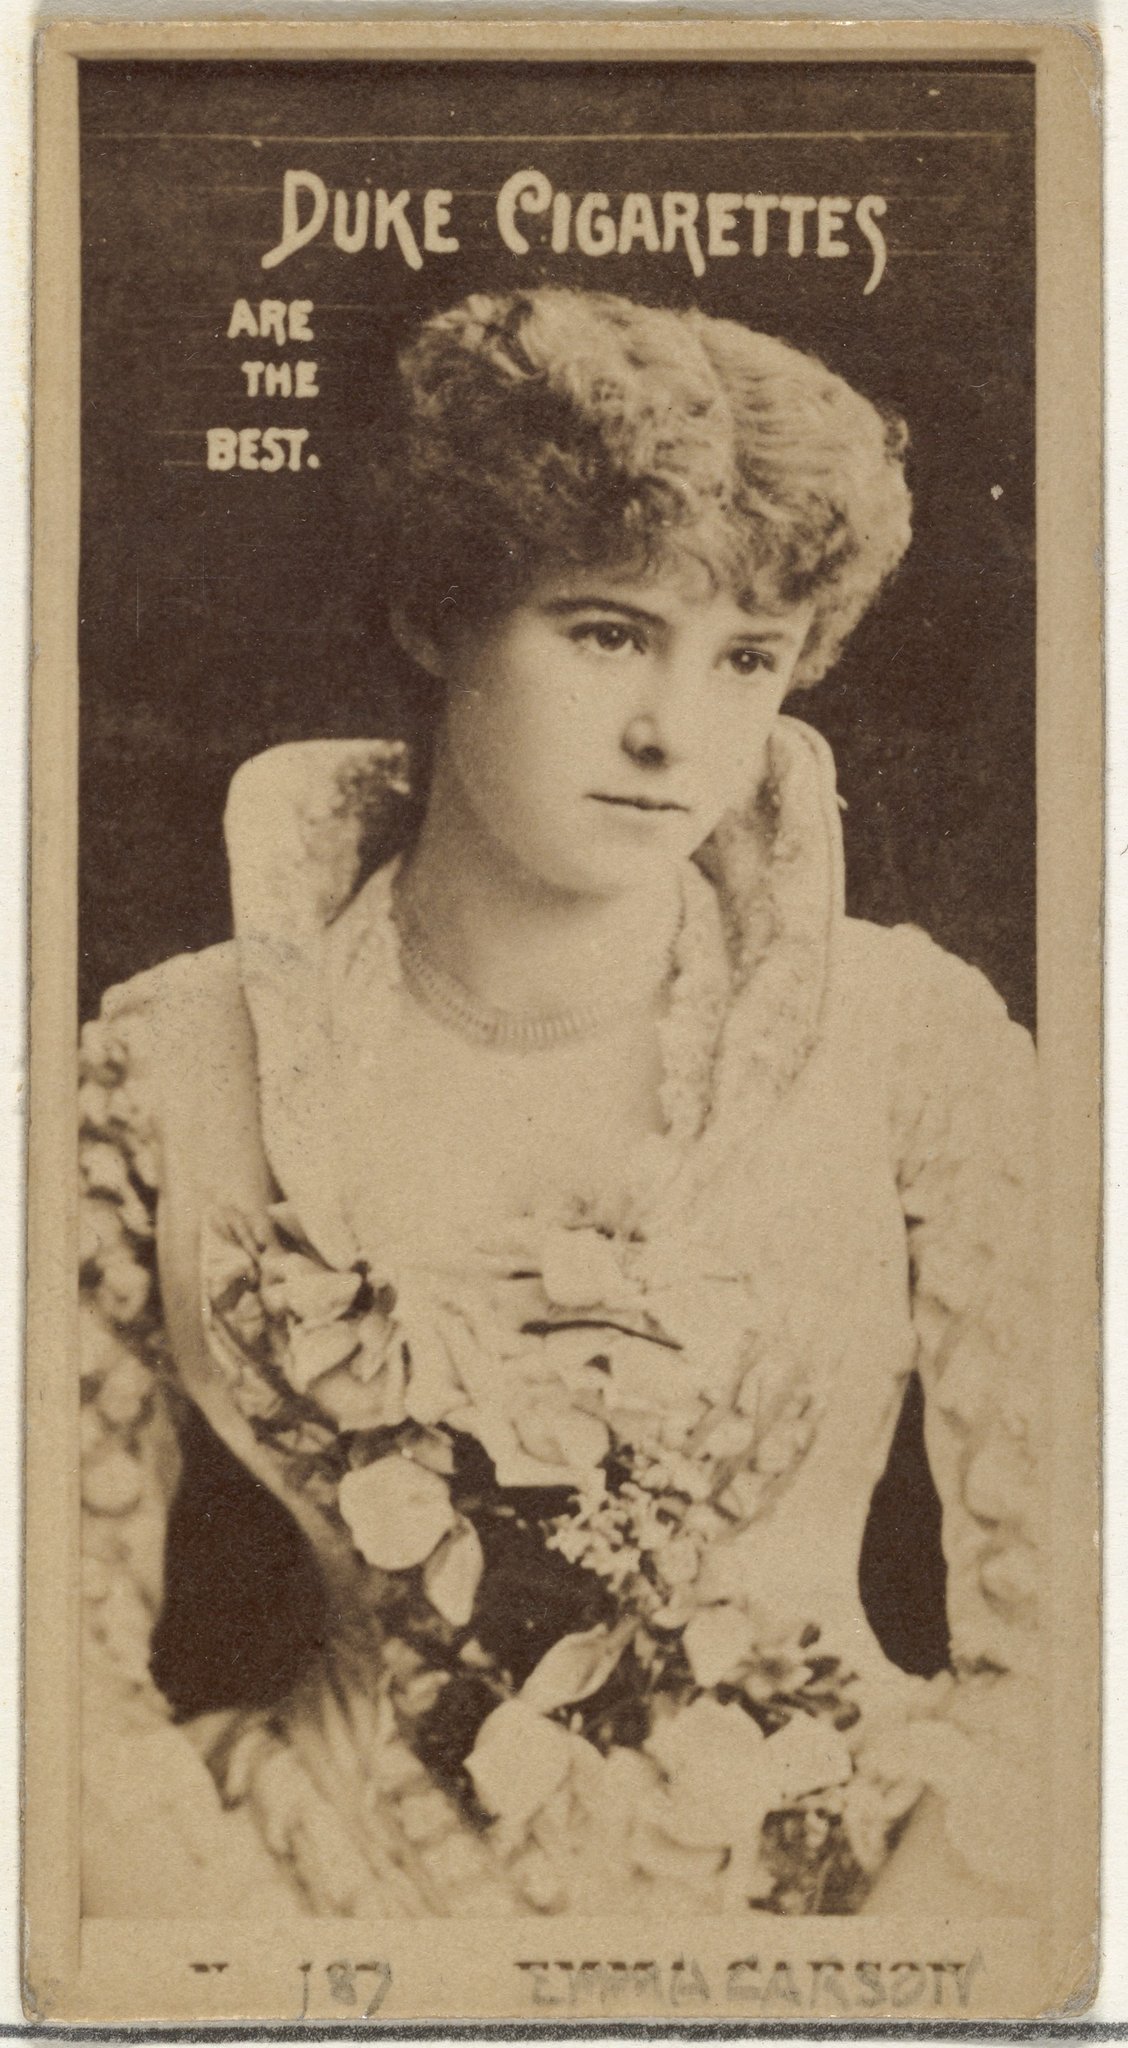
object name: photograph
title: Card Number 187, Emma Carson, from the Actors and Actresses series (N145-6) issued by Duke Sons & Co. to promote Duke Cigarettes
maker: w. duke, sons & co.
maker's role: publisher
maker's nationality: american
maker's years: 1870-1920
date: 1880-1889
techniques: albumen silver print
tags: portraits,women,actresses